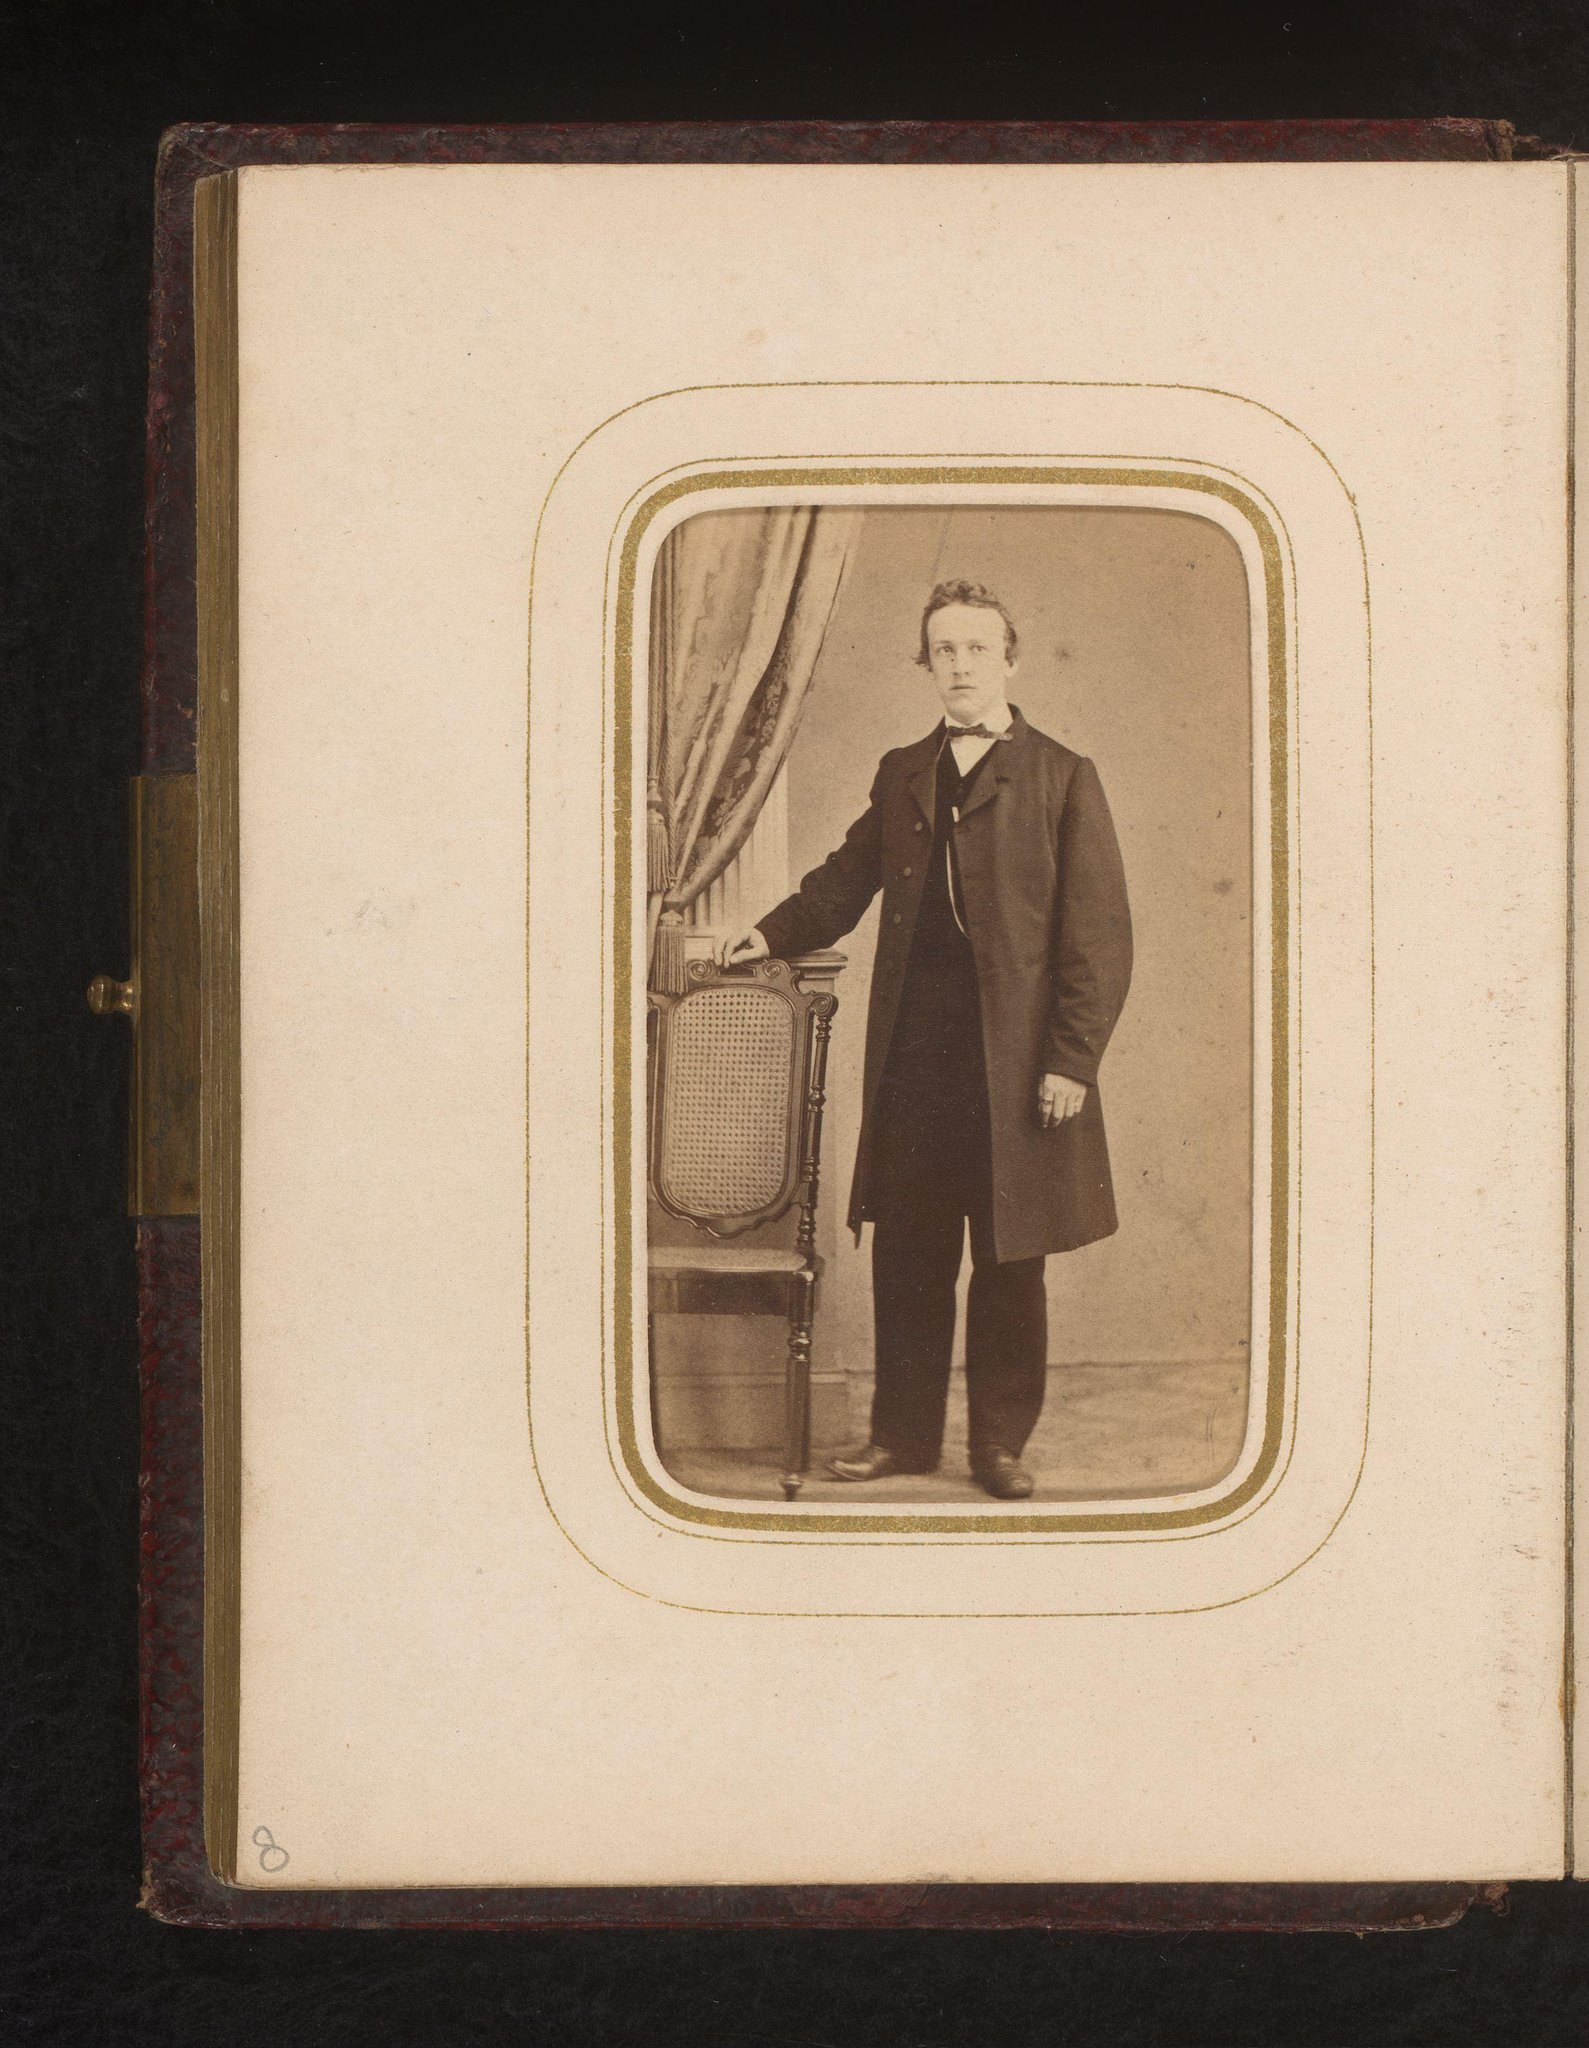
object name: album leaf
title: Portret van een staande jongeman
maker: Anonymous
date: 1860-1900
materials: cardboard, photographic support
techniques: albumen print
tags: boy (child between toddler and youth)